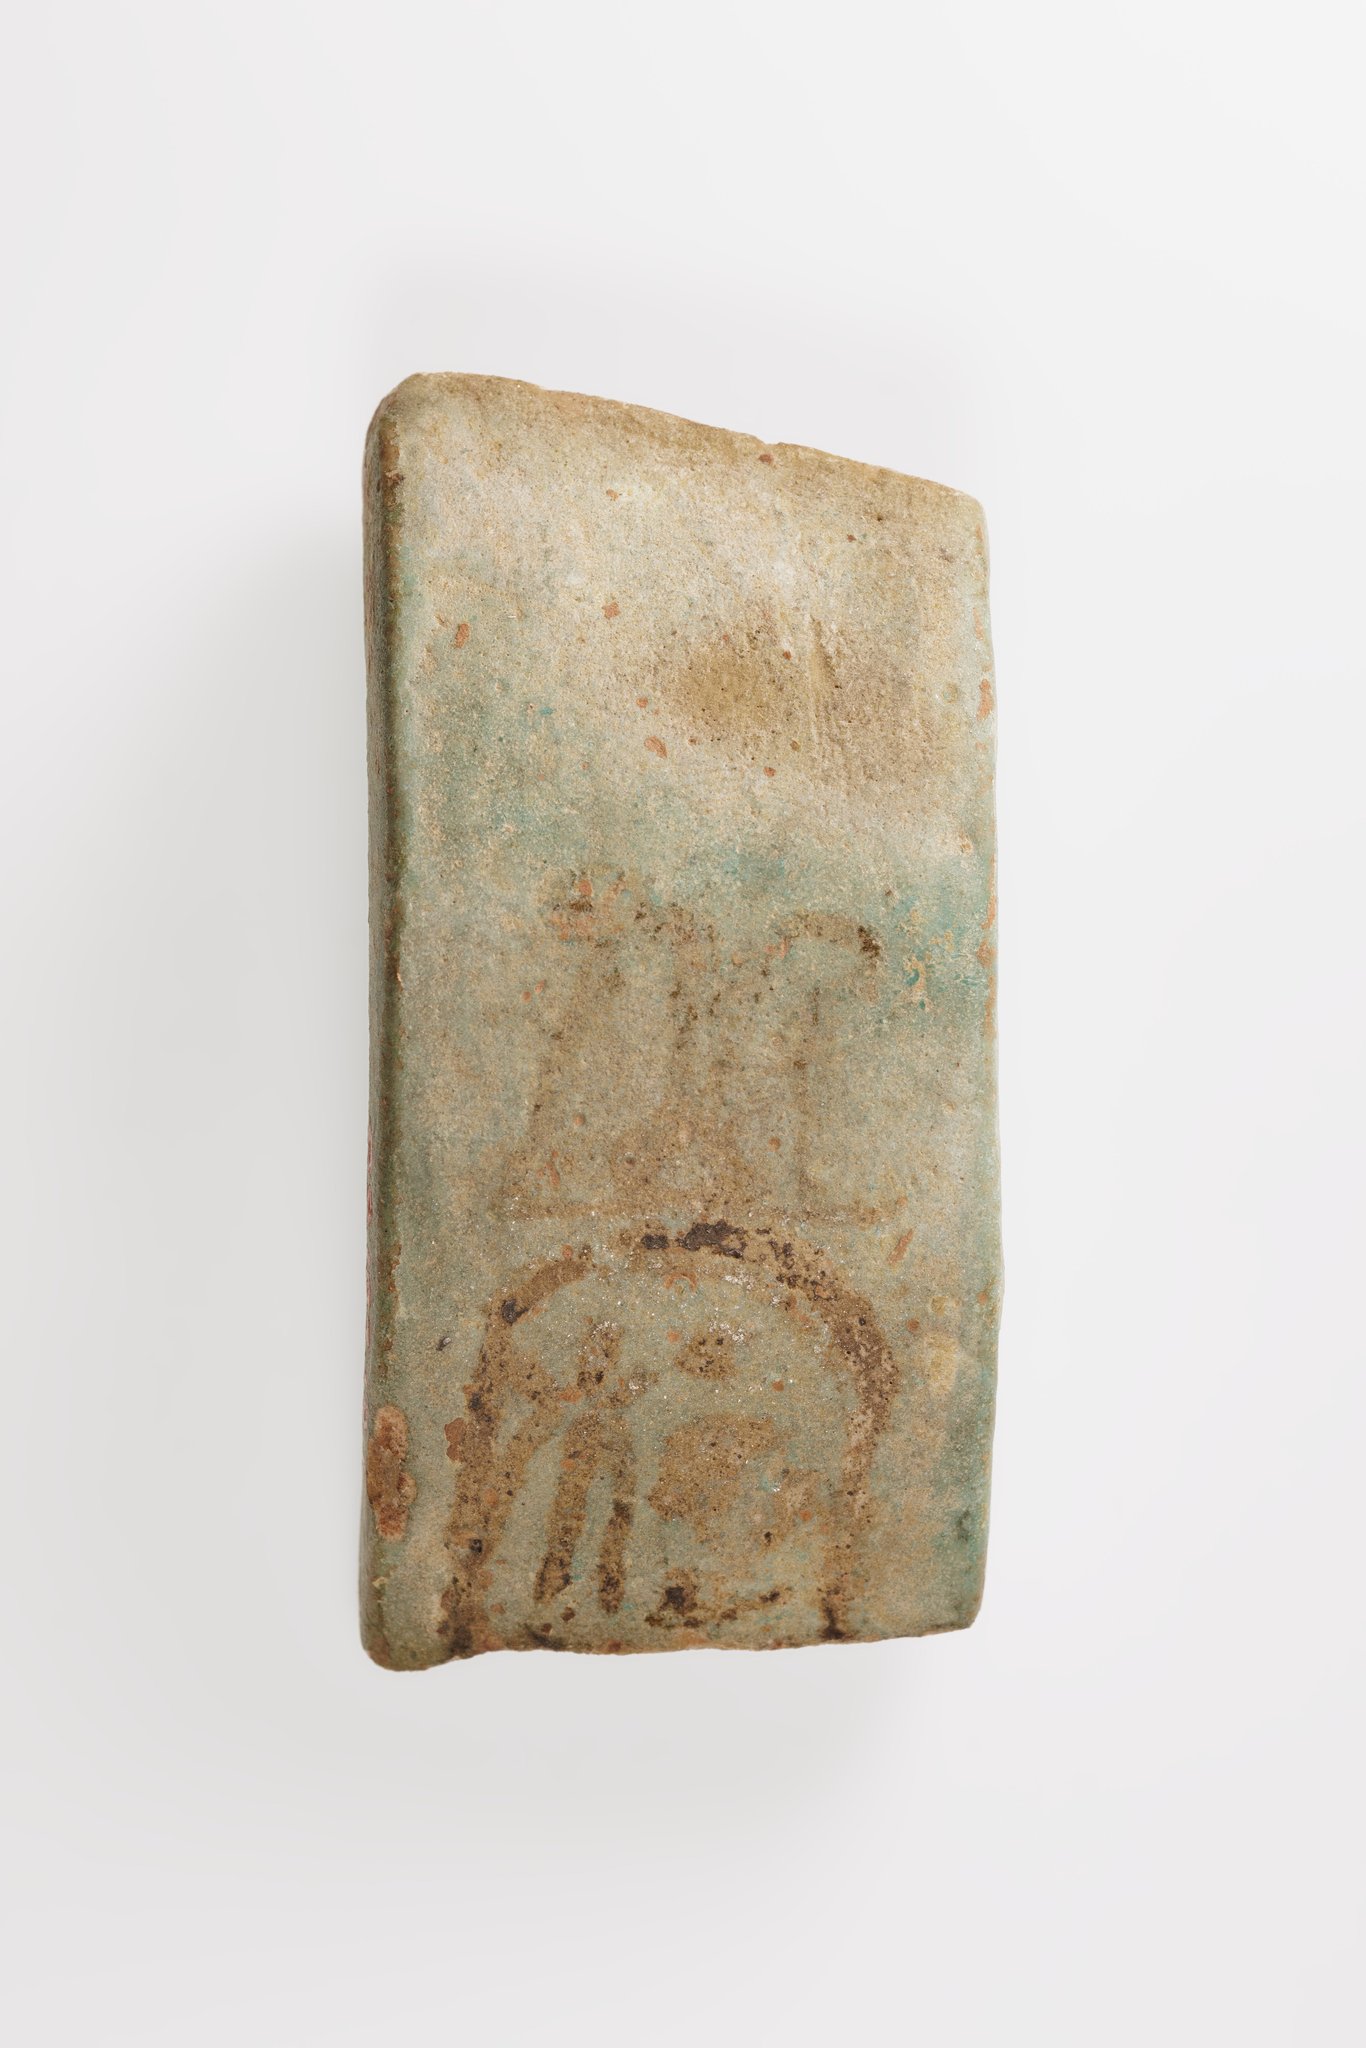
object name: votive bracelet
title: Fragment of a votive bracelet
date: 1295-1070 BCE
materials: faience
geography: egypt